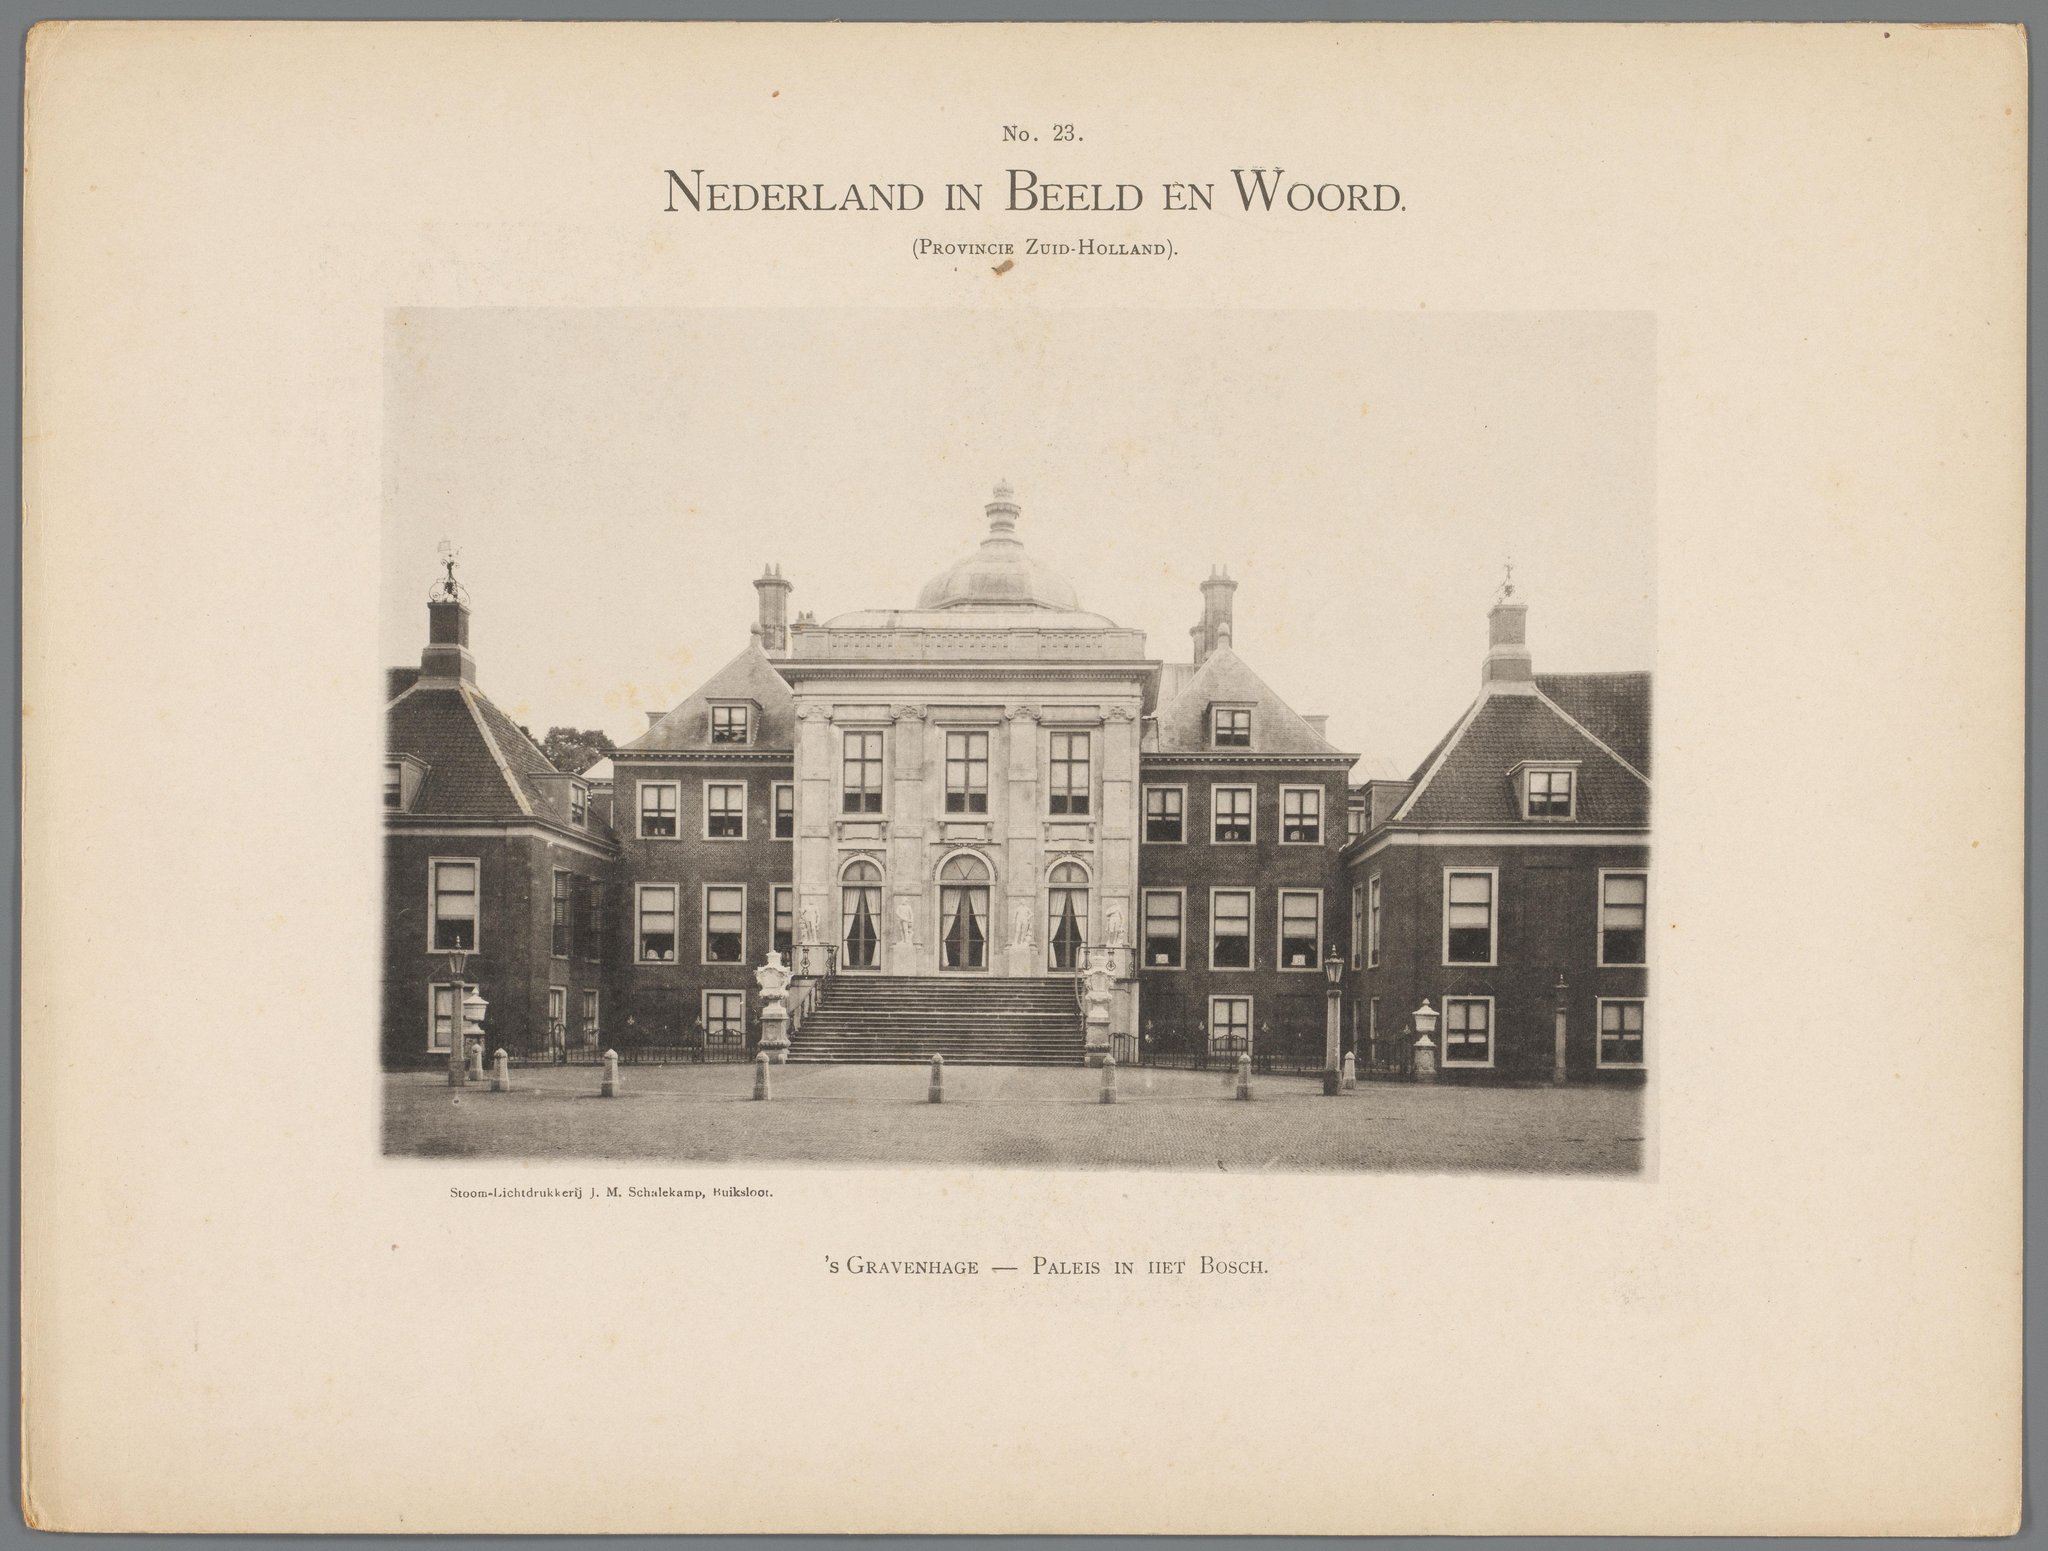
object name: photomechanical print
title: Nederland in beeld en woord. Provincie Zuid-Holland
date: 1890-1895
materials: cardboard, paper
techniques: photograph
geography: buiksloot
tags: palace, exterior ~ representation of a building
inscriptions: number: ‘No. 23.’